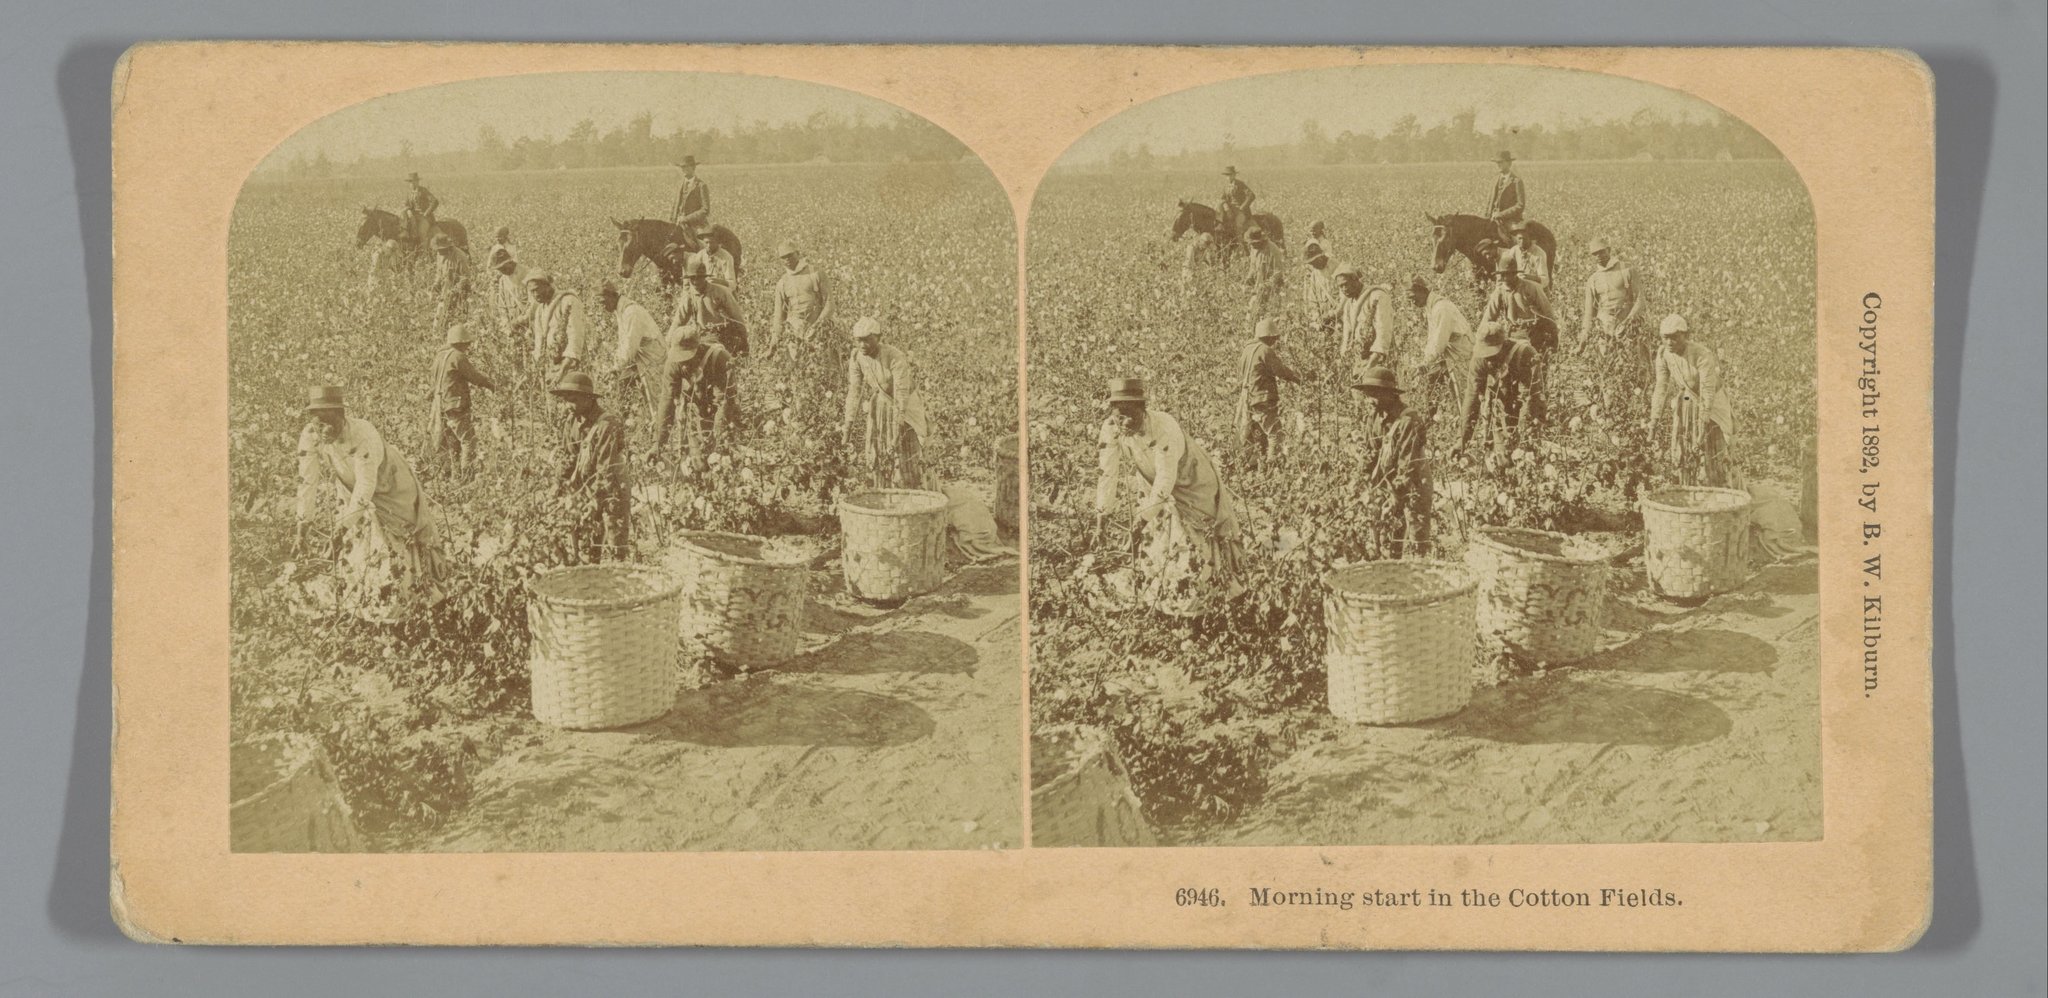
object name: stereograph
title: Morning start in the Cotton Fields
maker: benjamin west kilburn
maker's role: fotograaf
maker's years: 1827-1909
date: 1892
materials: cardboard, paper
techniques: albumen print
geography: littleton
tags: cotton (material ~ textile industry)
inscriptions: copyright notice: ‘Copyright 1892, by B. W. Kilburn.’, number: ‘6946’